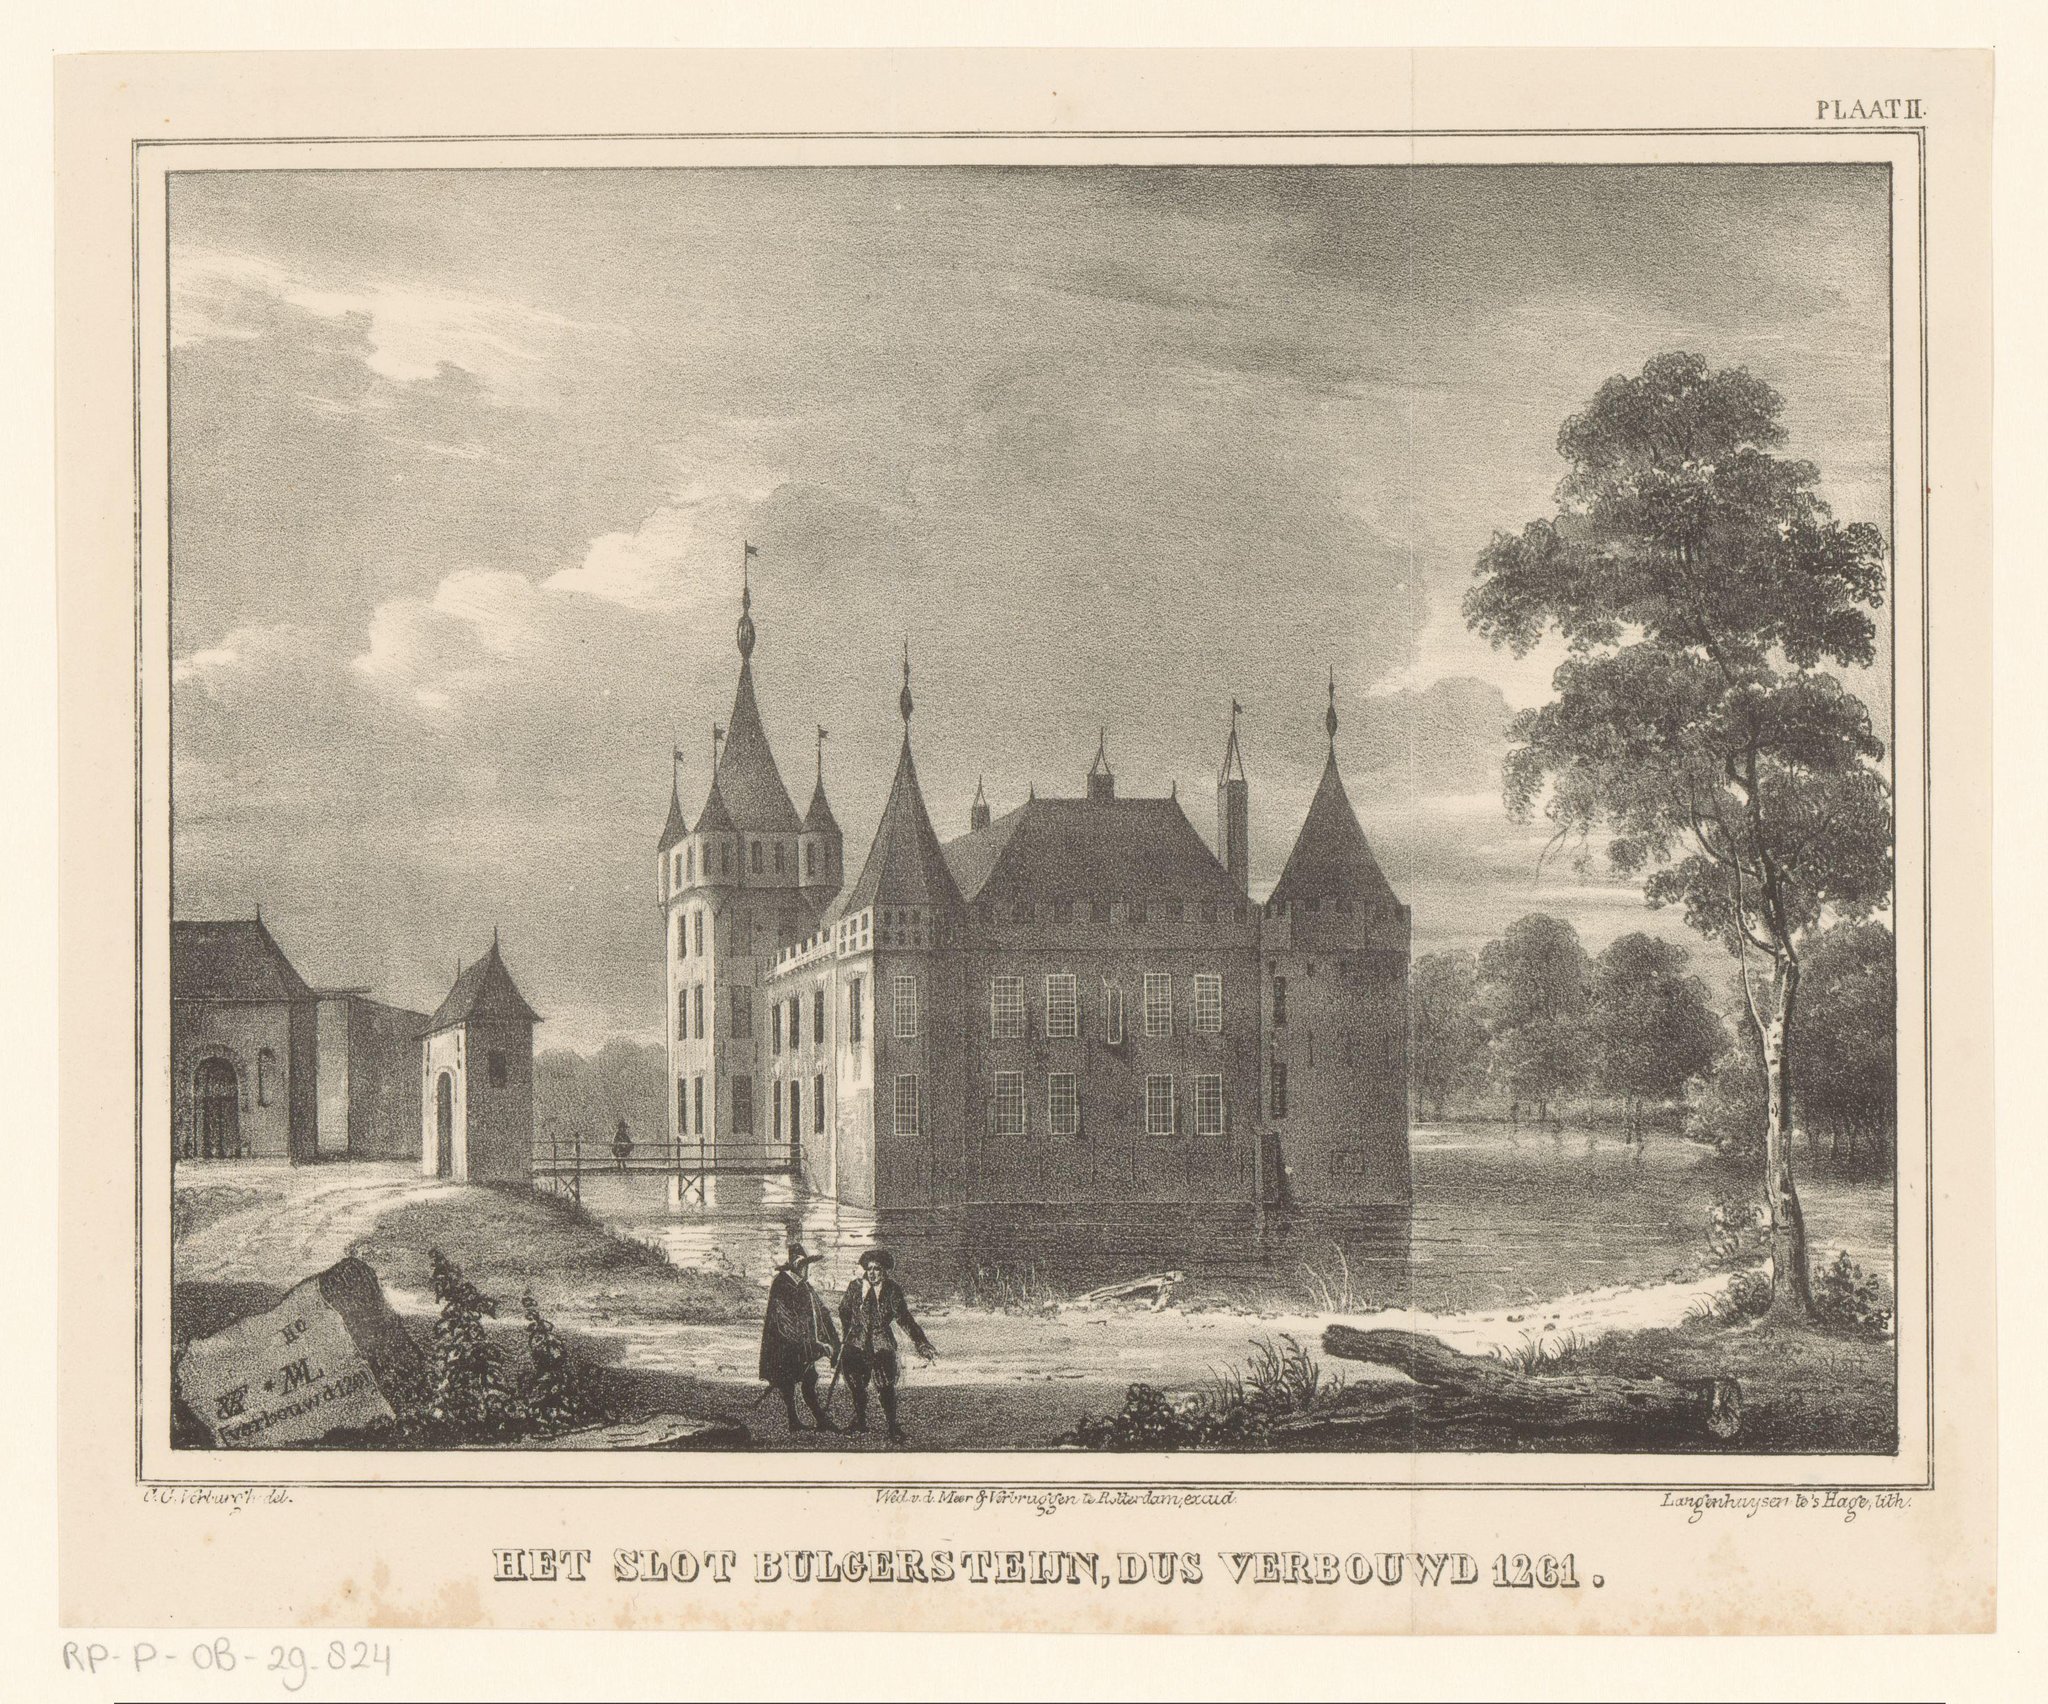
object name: print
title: Het slot Bulgersteijn, dus verbouwd 1261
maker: a.p. van langenhuijsen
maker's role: printer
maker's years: 1797-1860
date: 1830-1846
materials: paper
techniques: lithograph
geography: rotterdam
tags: castle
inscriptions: collector's mark: Lugt 2228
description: Twee mannen op een pad voor kasteel Bulgersteyn. Rechts boven genummerd Plaat II.